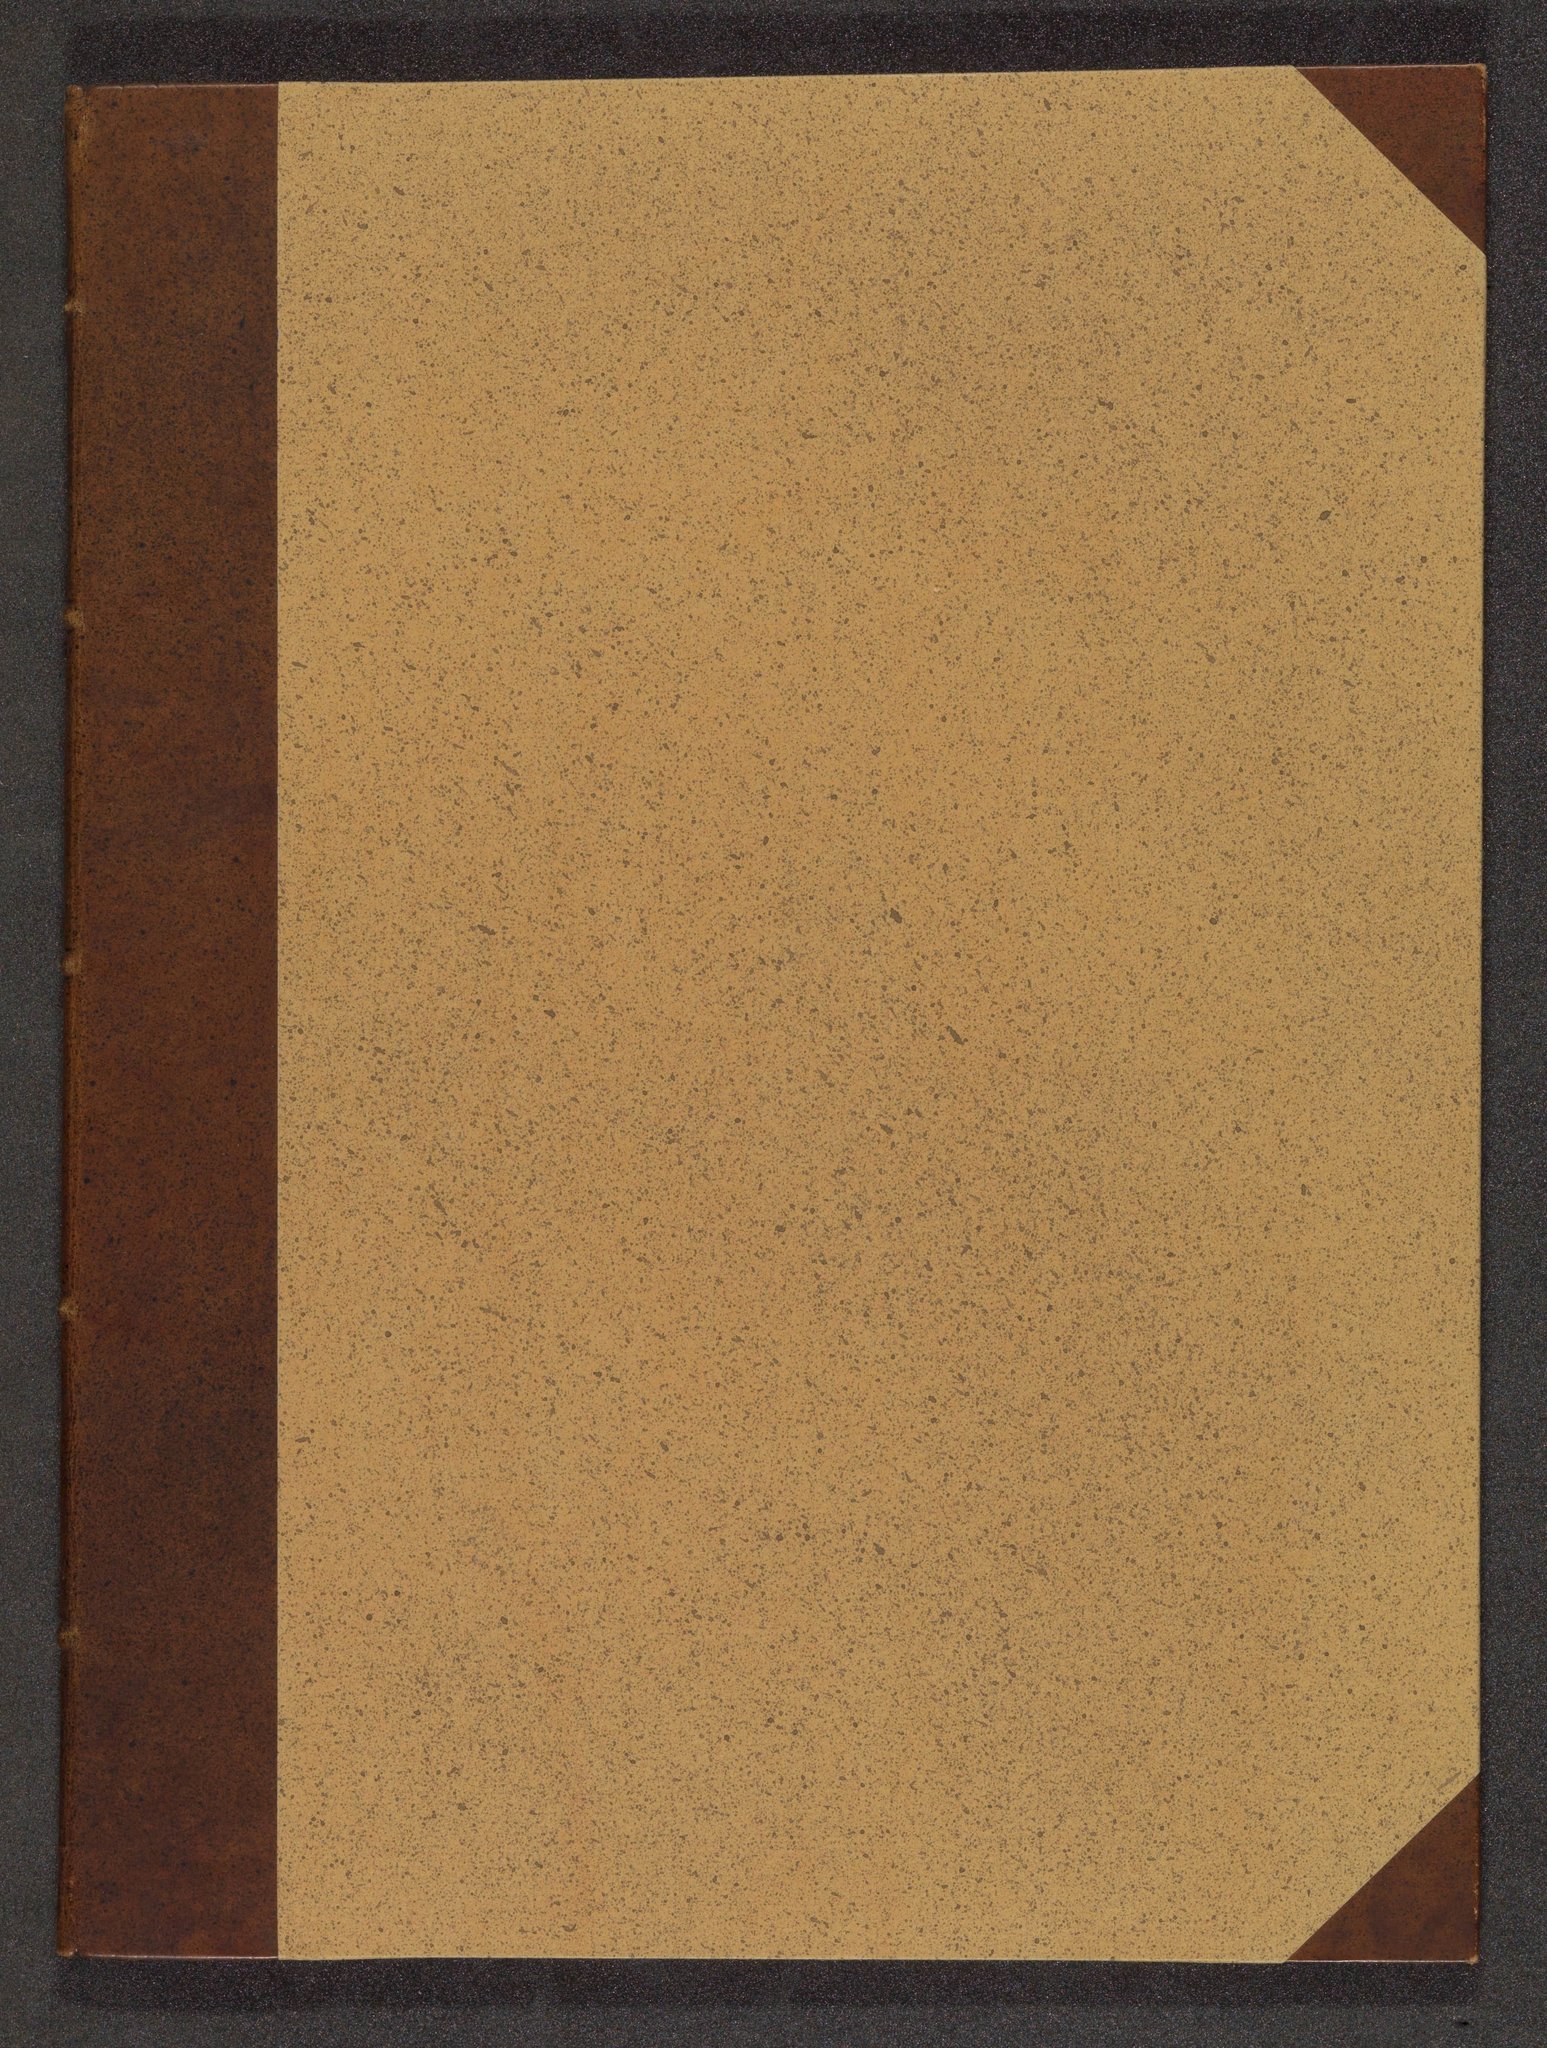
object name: prentrecueil, prentenalbum, prentalbum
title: Varie figvre academiche (...) / Diversche figvren wt de academia (...)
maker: pieter de jode (i)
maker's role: draughtsman, print maker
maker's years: 1570-1634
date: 1629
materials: cardboard, paper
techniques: bookbinding, engraving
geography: antwerp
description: Album met een serie tekenvoorbeelden met de titel 'Varie figvre academiche ... / Diversche figvren wt de academia ...', bestaande uit een titelprent en 24 prenten, in een kartonnen band. Voor- en achterin een schutblad.